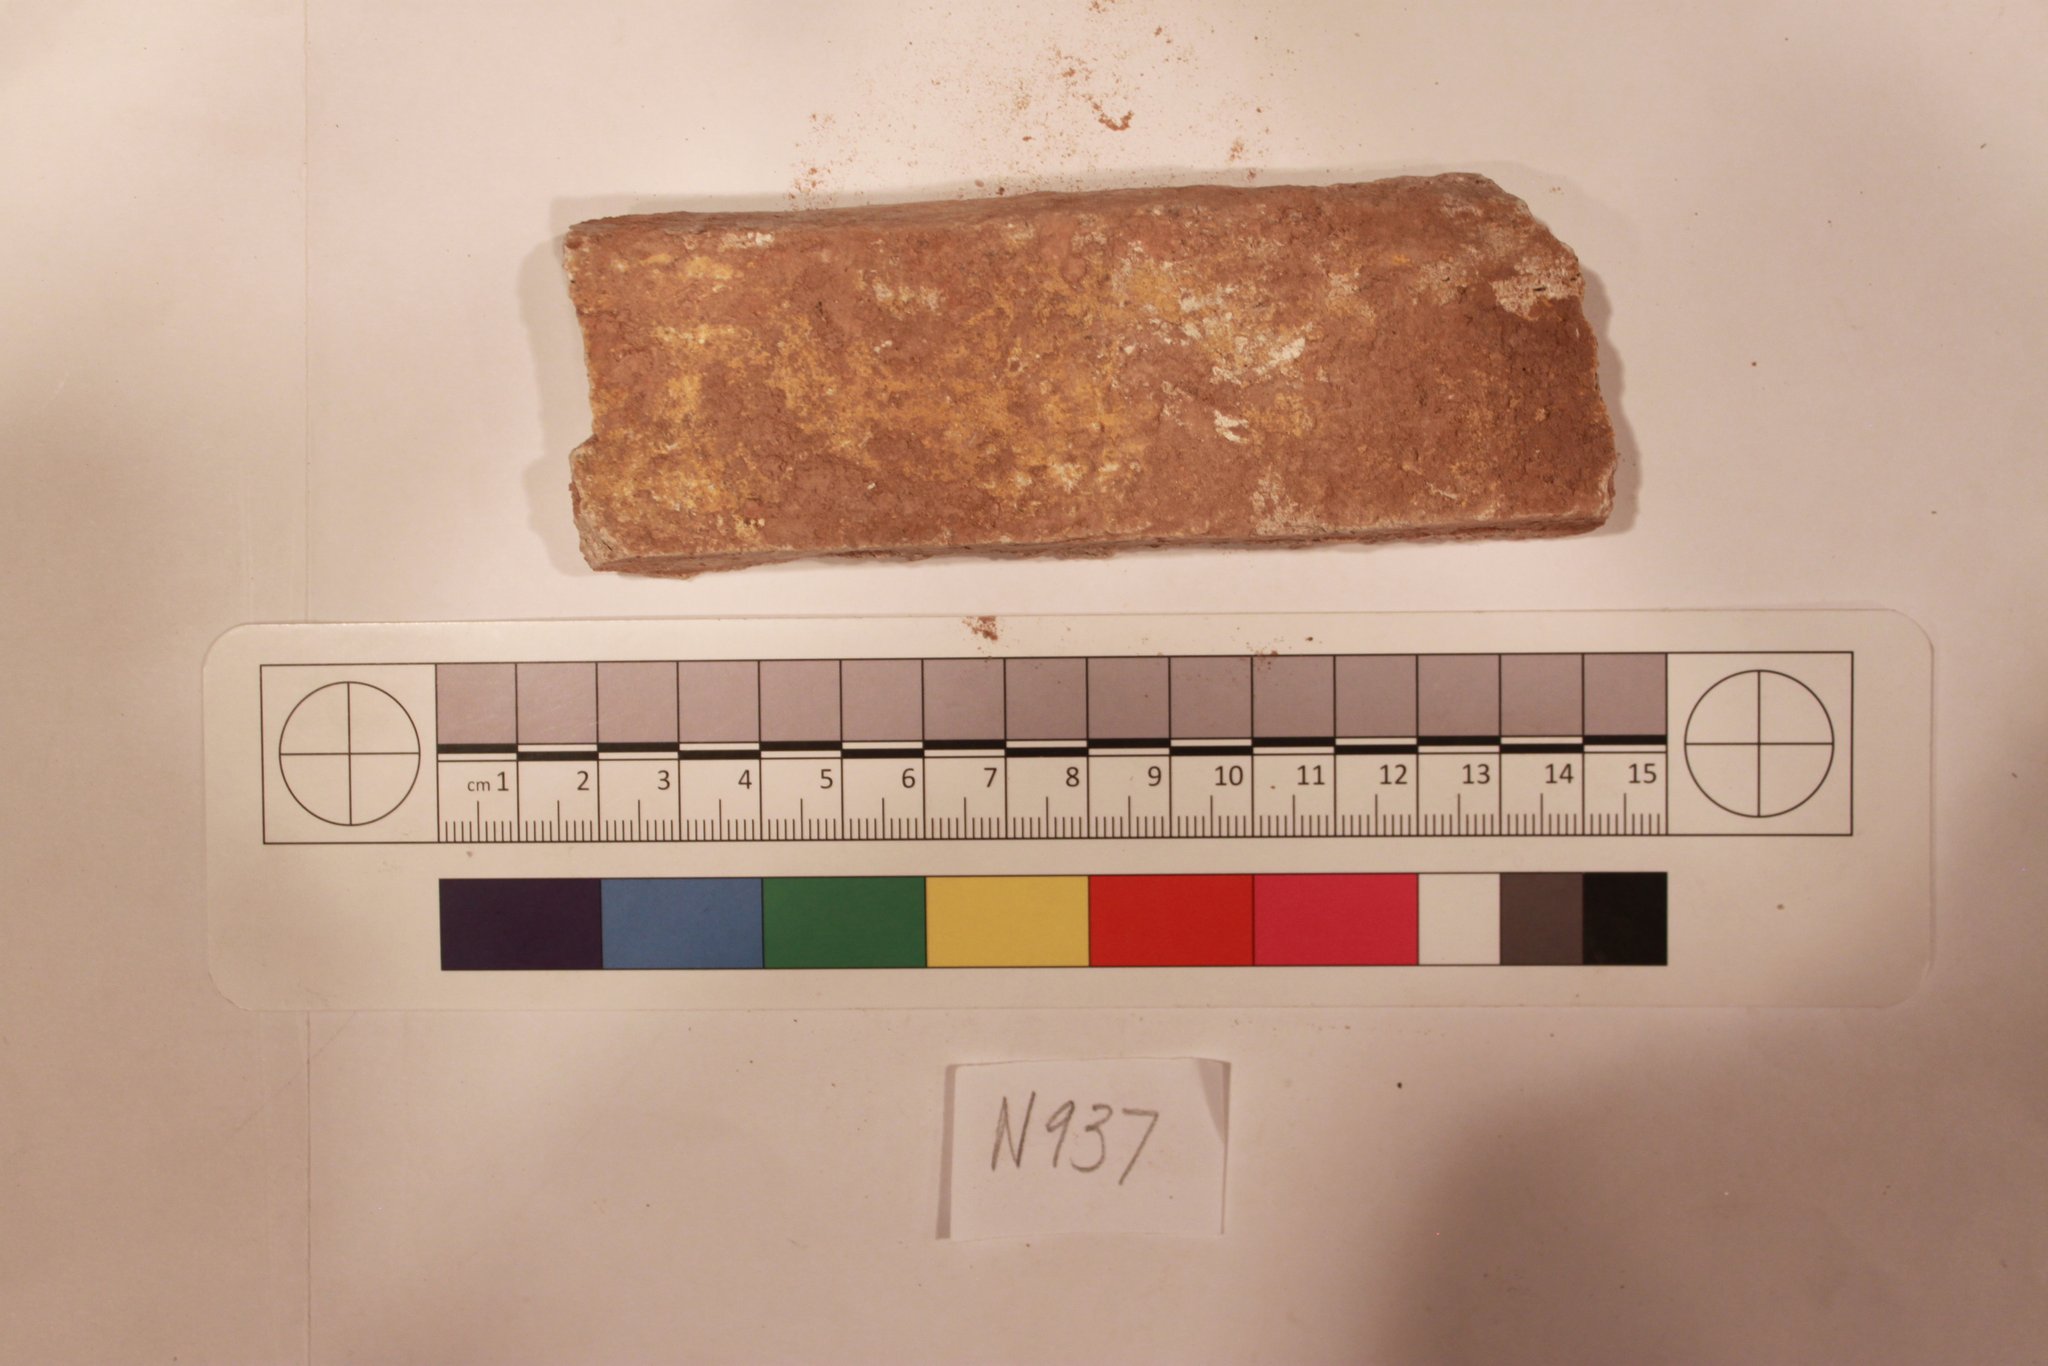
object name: fragment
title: Stucco Fragment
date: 701-1200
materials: plaster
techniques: carving, painting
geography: iran